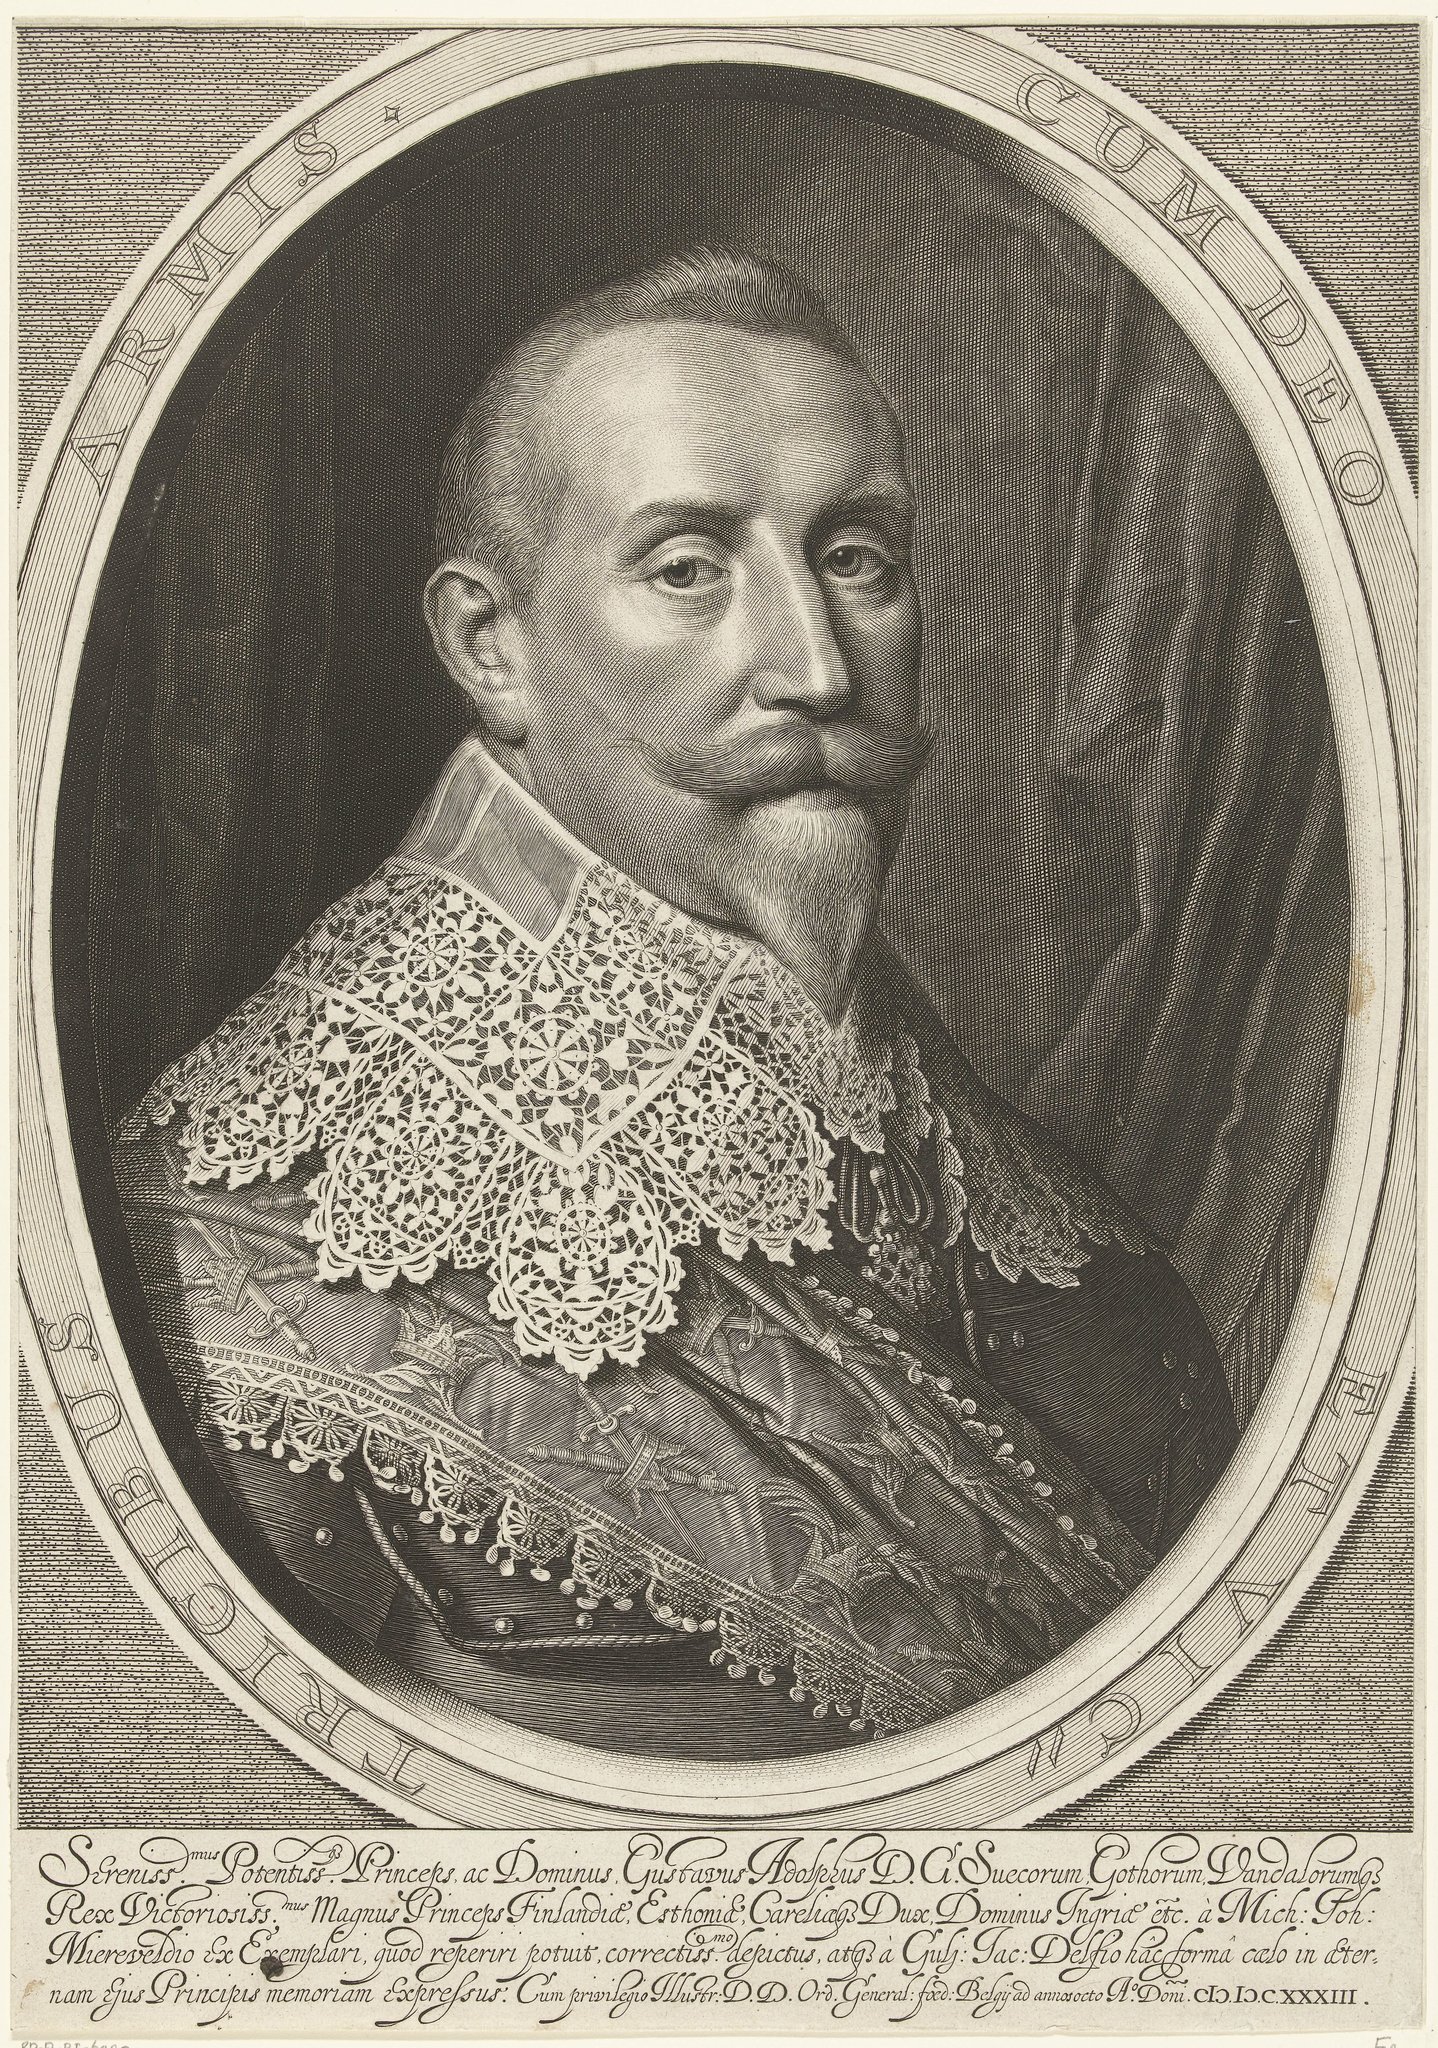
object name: print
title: Portret van Gustaaf II, koning van Zweden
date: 1633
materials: paper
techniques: engraving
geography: delft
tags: king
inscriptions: collector's mark: Lugt 2228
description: Portret van Gustaaf II, koning van Zweden, borststuk met platte kanten kraag en harnas in ovale omlijsting met Latijns motto. In ondermarge vier regels Latijns opschrift.